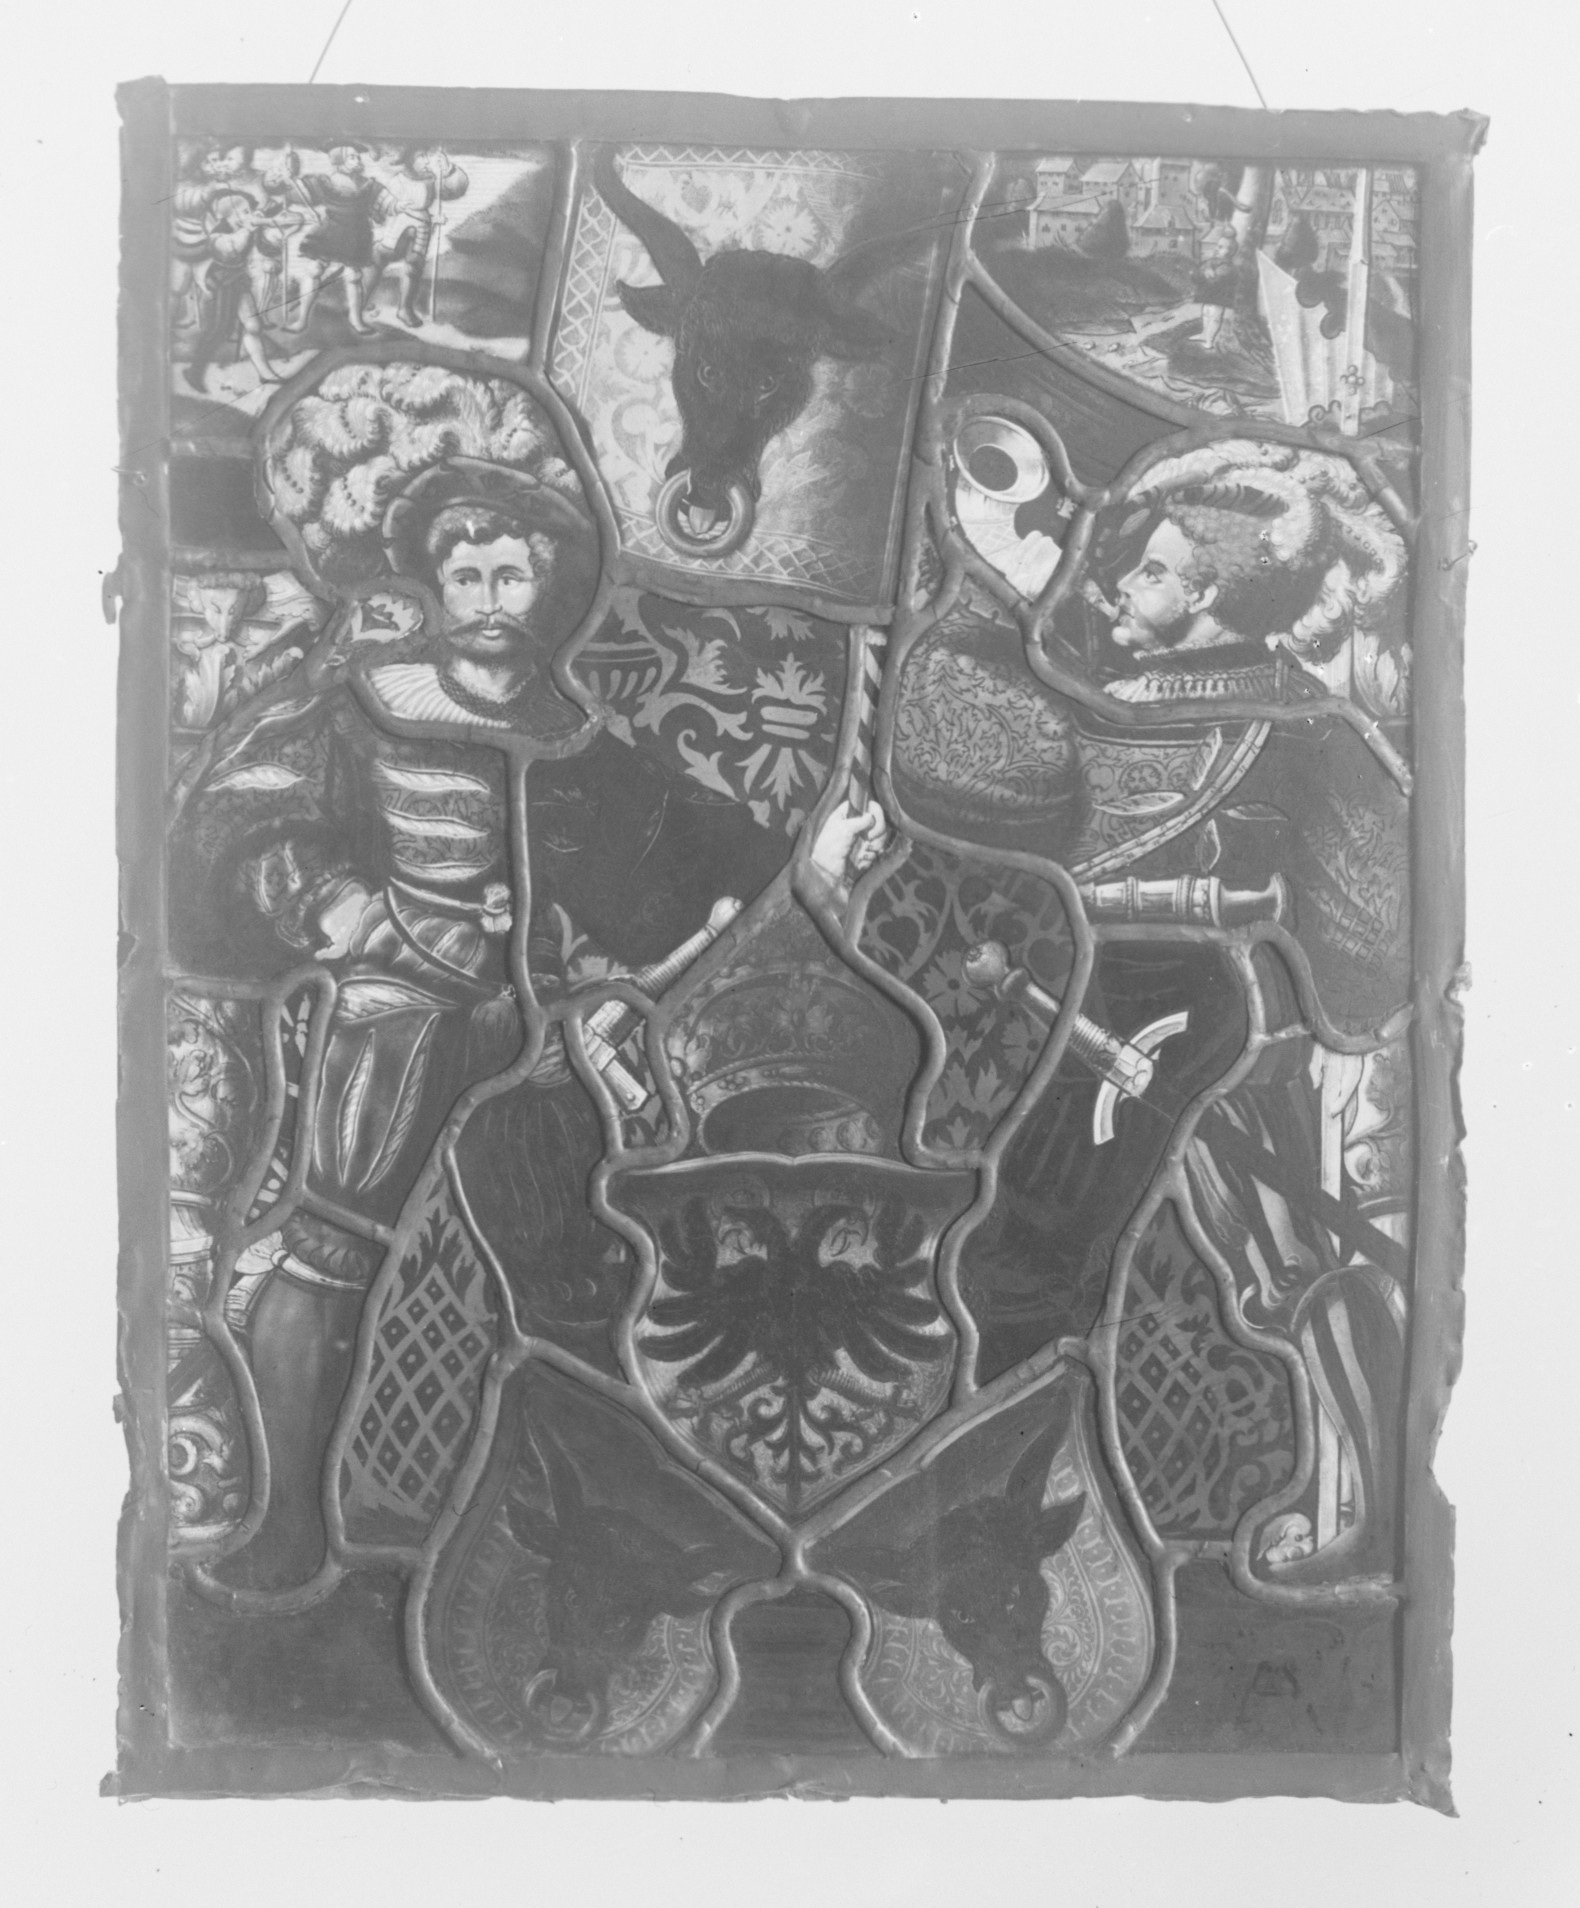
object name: armorial panel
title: Arms of the Canton of Uri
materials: glass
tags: animals,swords,men,coat of arms